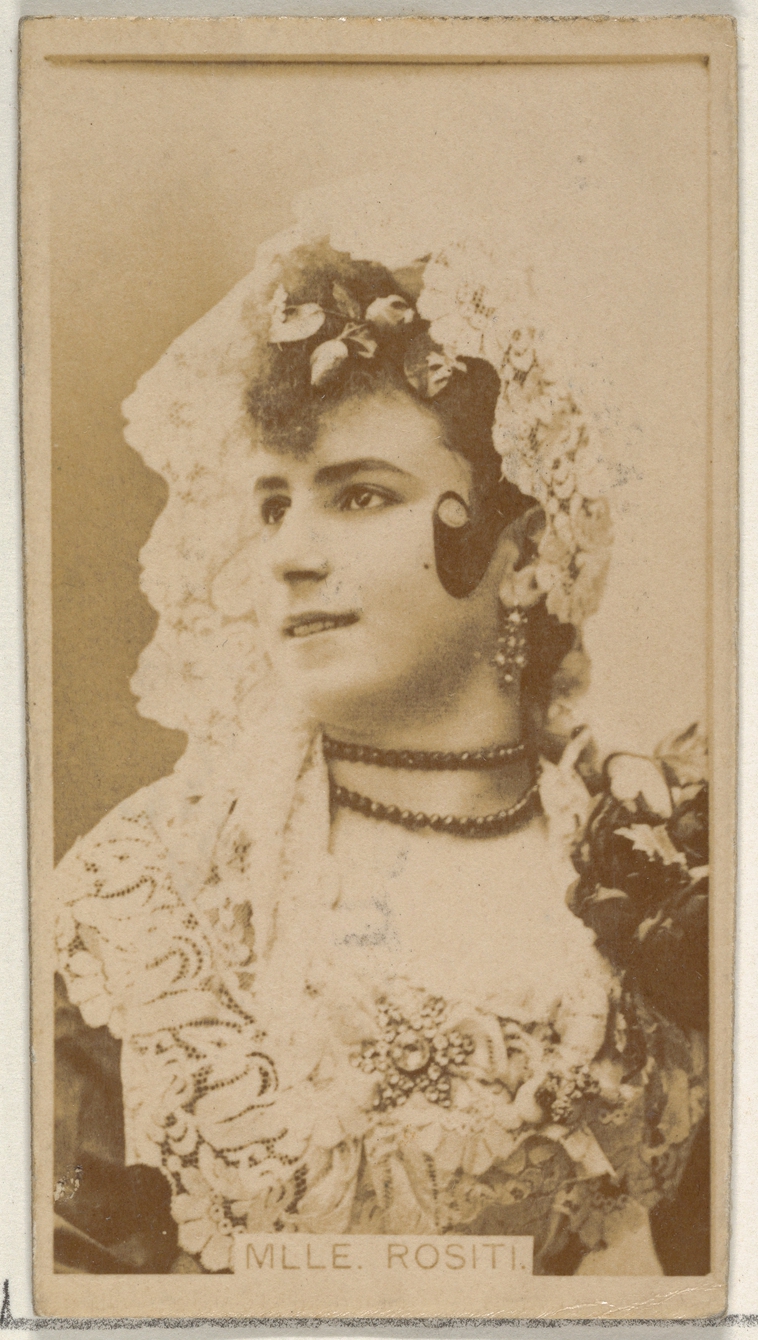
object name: photograph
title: Mlle. Rositi, from the Actors and Actresses series (N45, Type 8) for Virgina Brights Cigarettes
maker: allen & ginter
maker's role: artist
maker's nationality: american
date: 1888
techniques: albumen silver print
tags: portraits,women,actresses